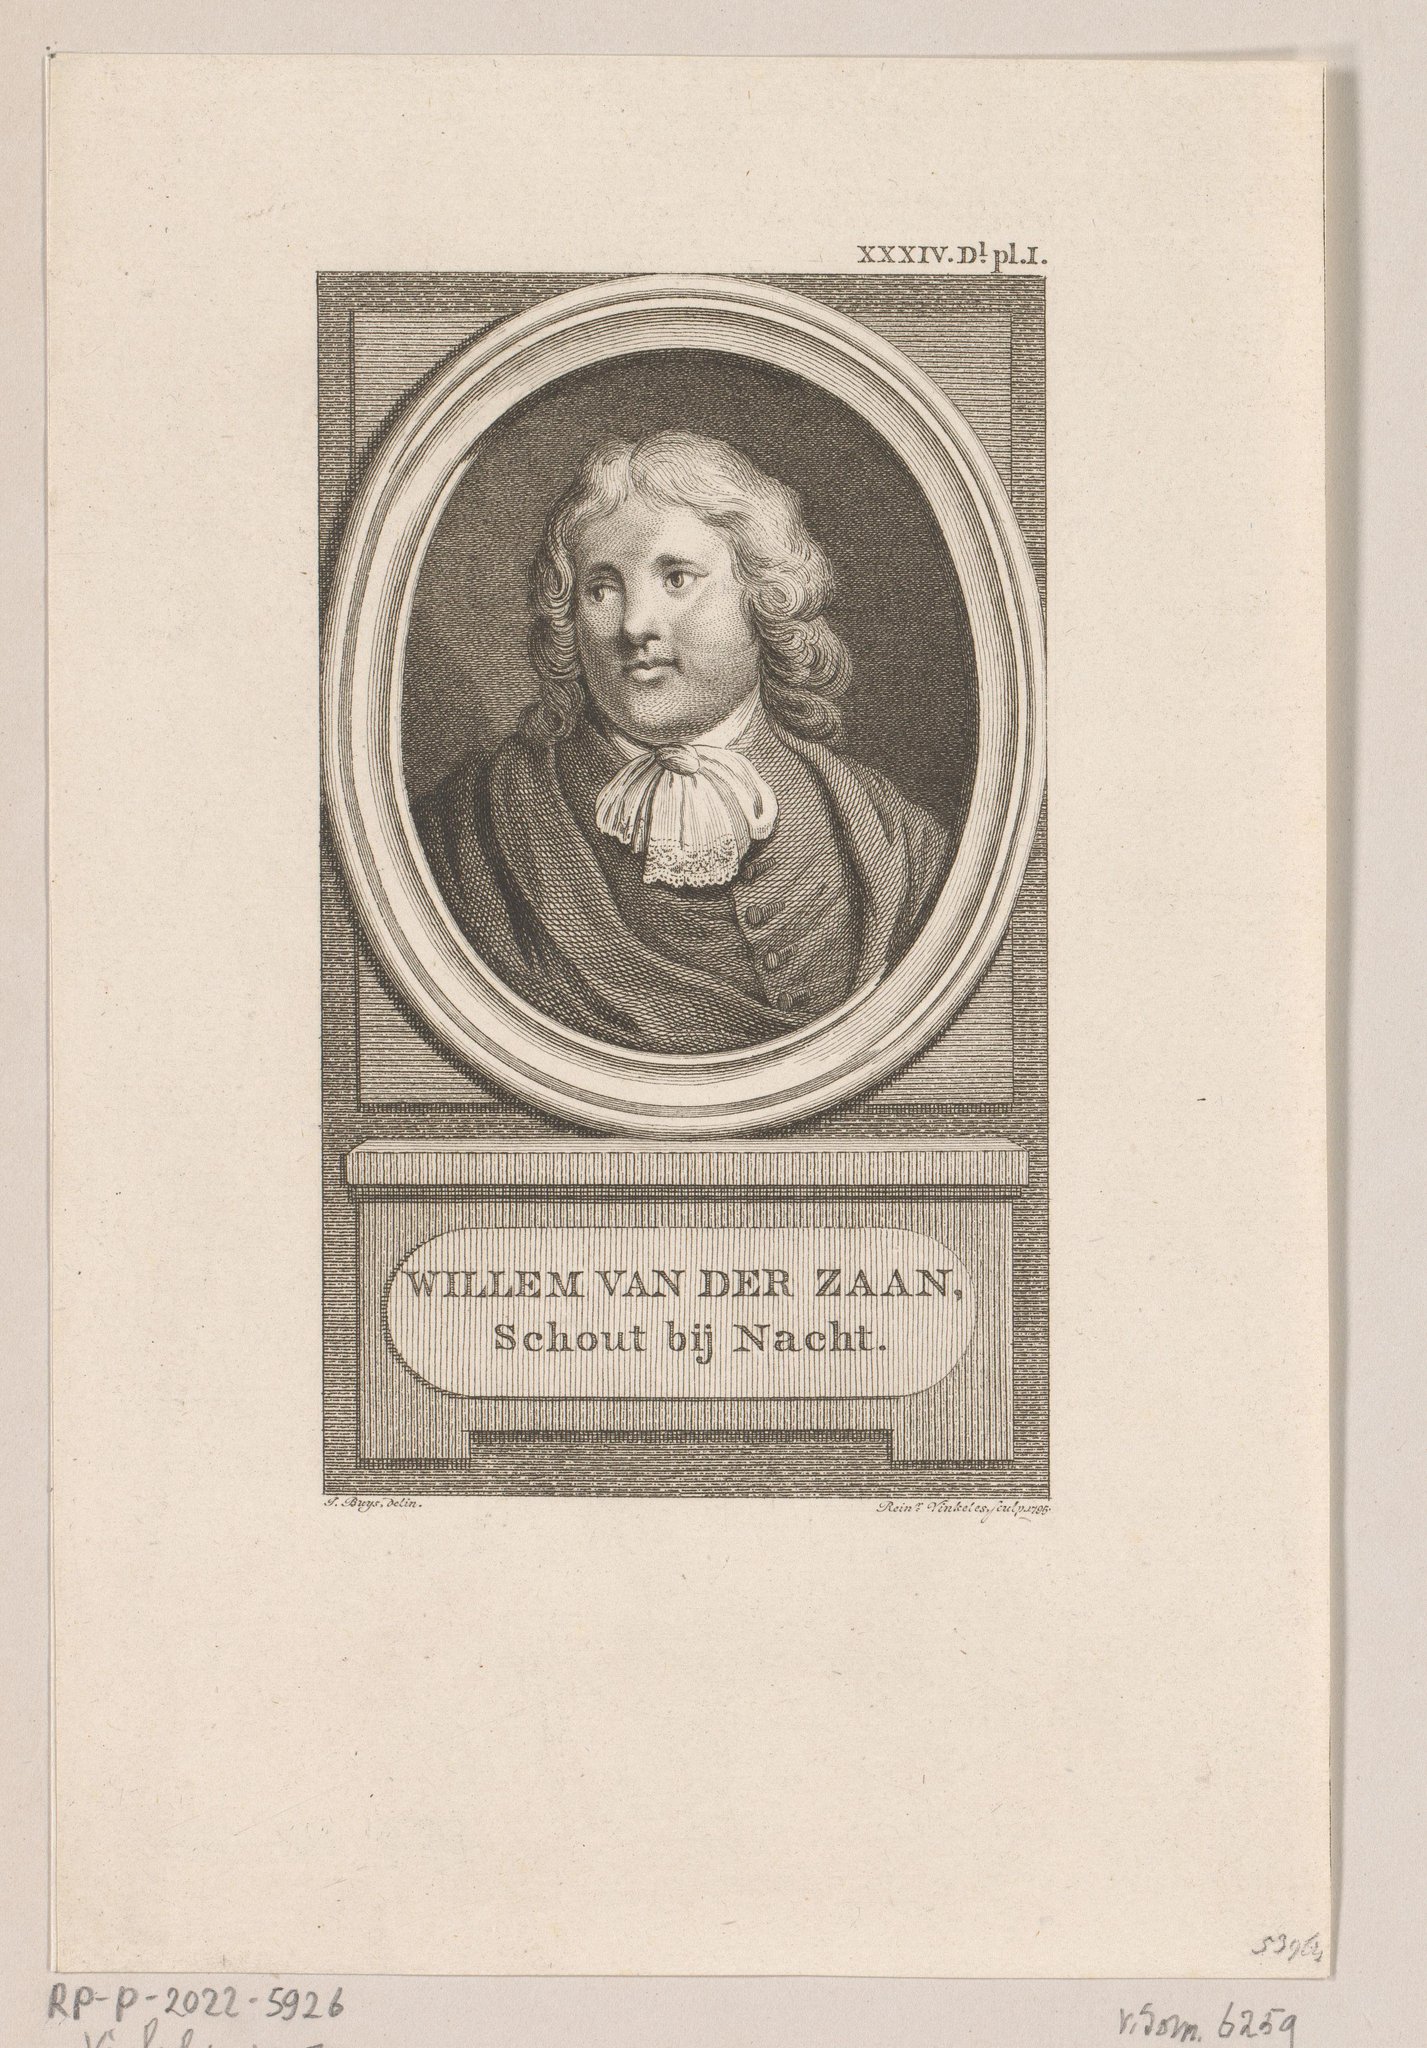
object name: print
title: Portret van Willem van der Zaan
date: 1795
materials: paper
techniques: engraving, etching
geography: amsterdam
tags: ranks in the army, historical persons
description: Prent waarschijnlijk uit: Kok, Jacobus. Vaderlandsch woordenboek (...). Amsterdam: Johannes Allart, 1795, dl. 34.